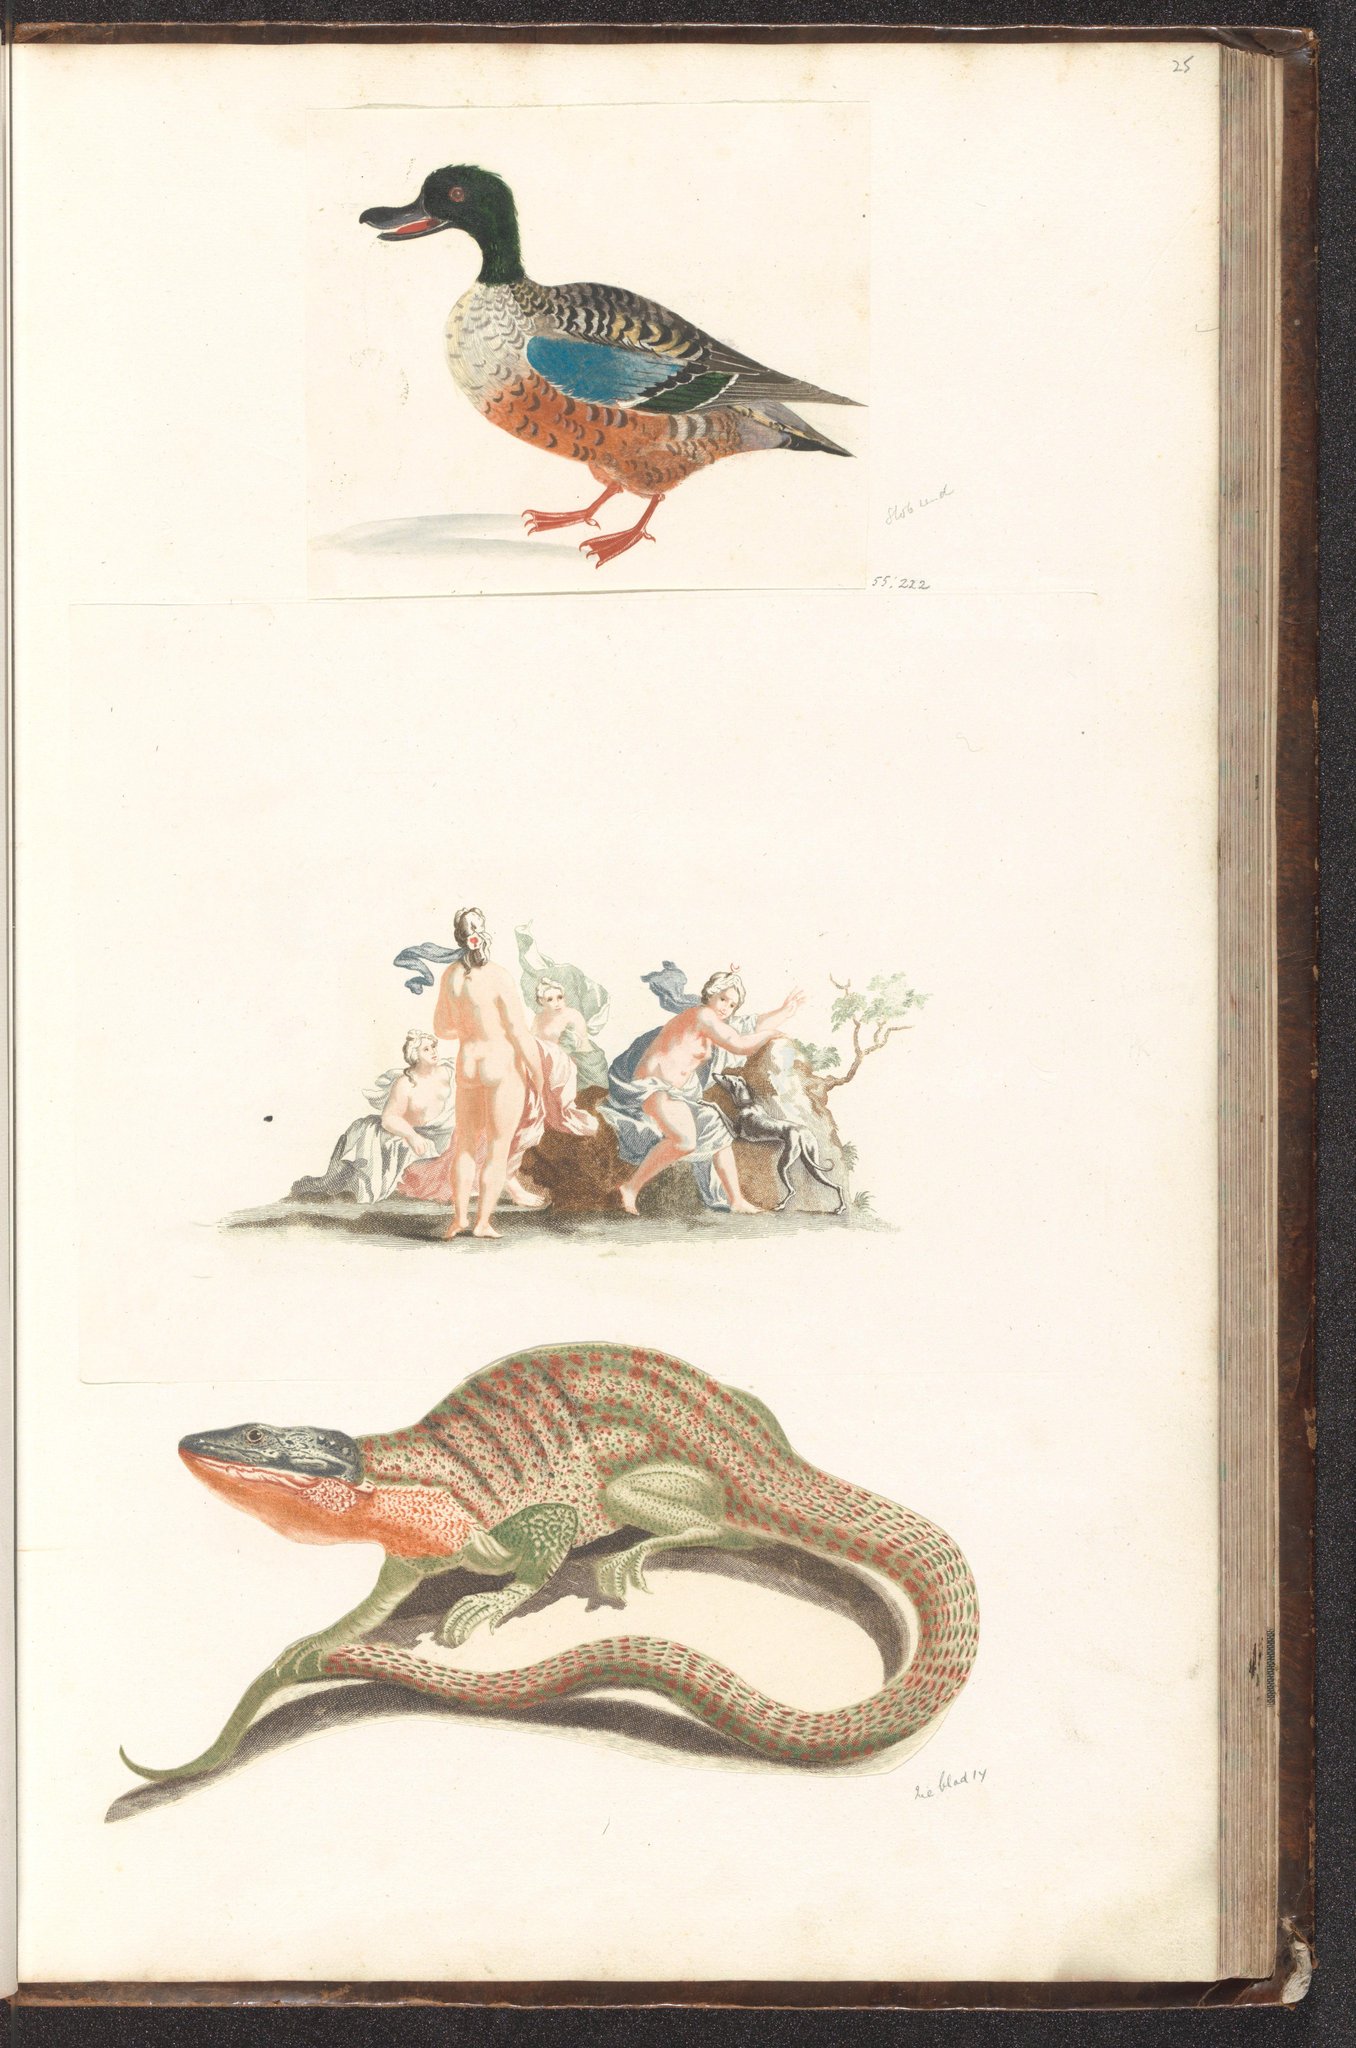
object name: album leaf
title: Diana en haar nimfen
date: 1688-1698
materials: paper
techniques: etching, hand coloring, lithography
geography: netherlands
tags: companions, nymphs of diana; 'ninfe di diana' (ripa), (story of) diana (artemis)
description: Diana, maangodin en godin van de jacht, met een jachthond. Naast haar drie nimfen. Deze prent maakt deel uit van een album.